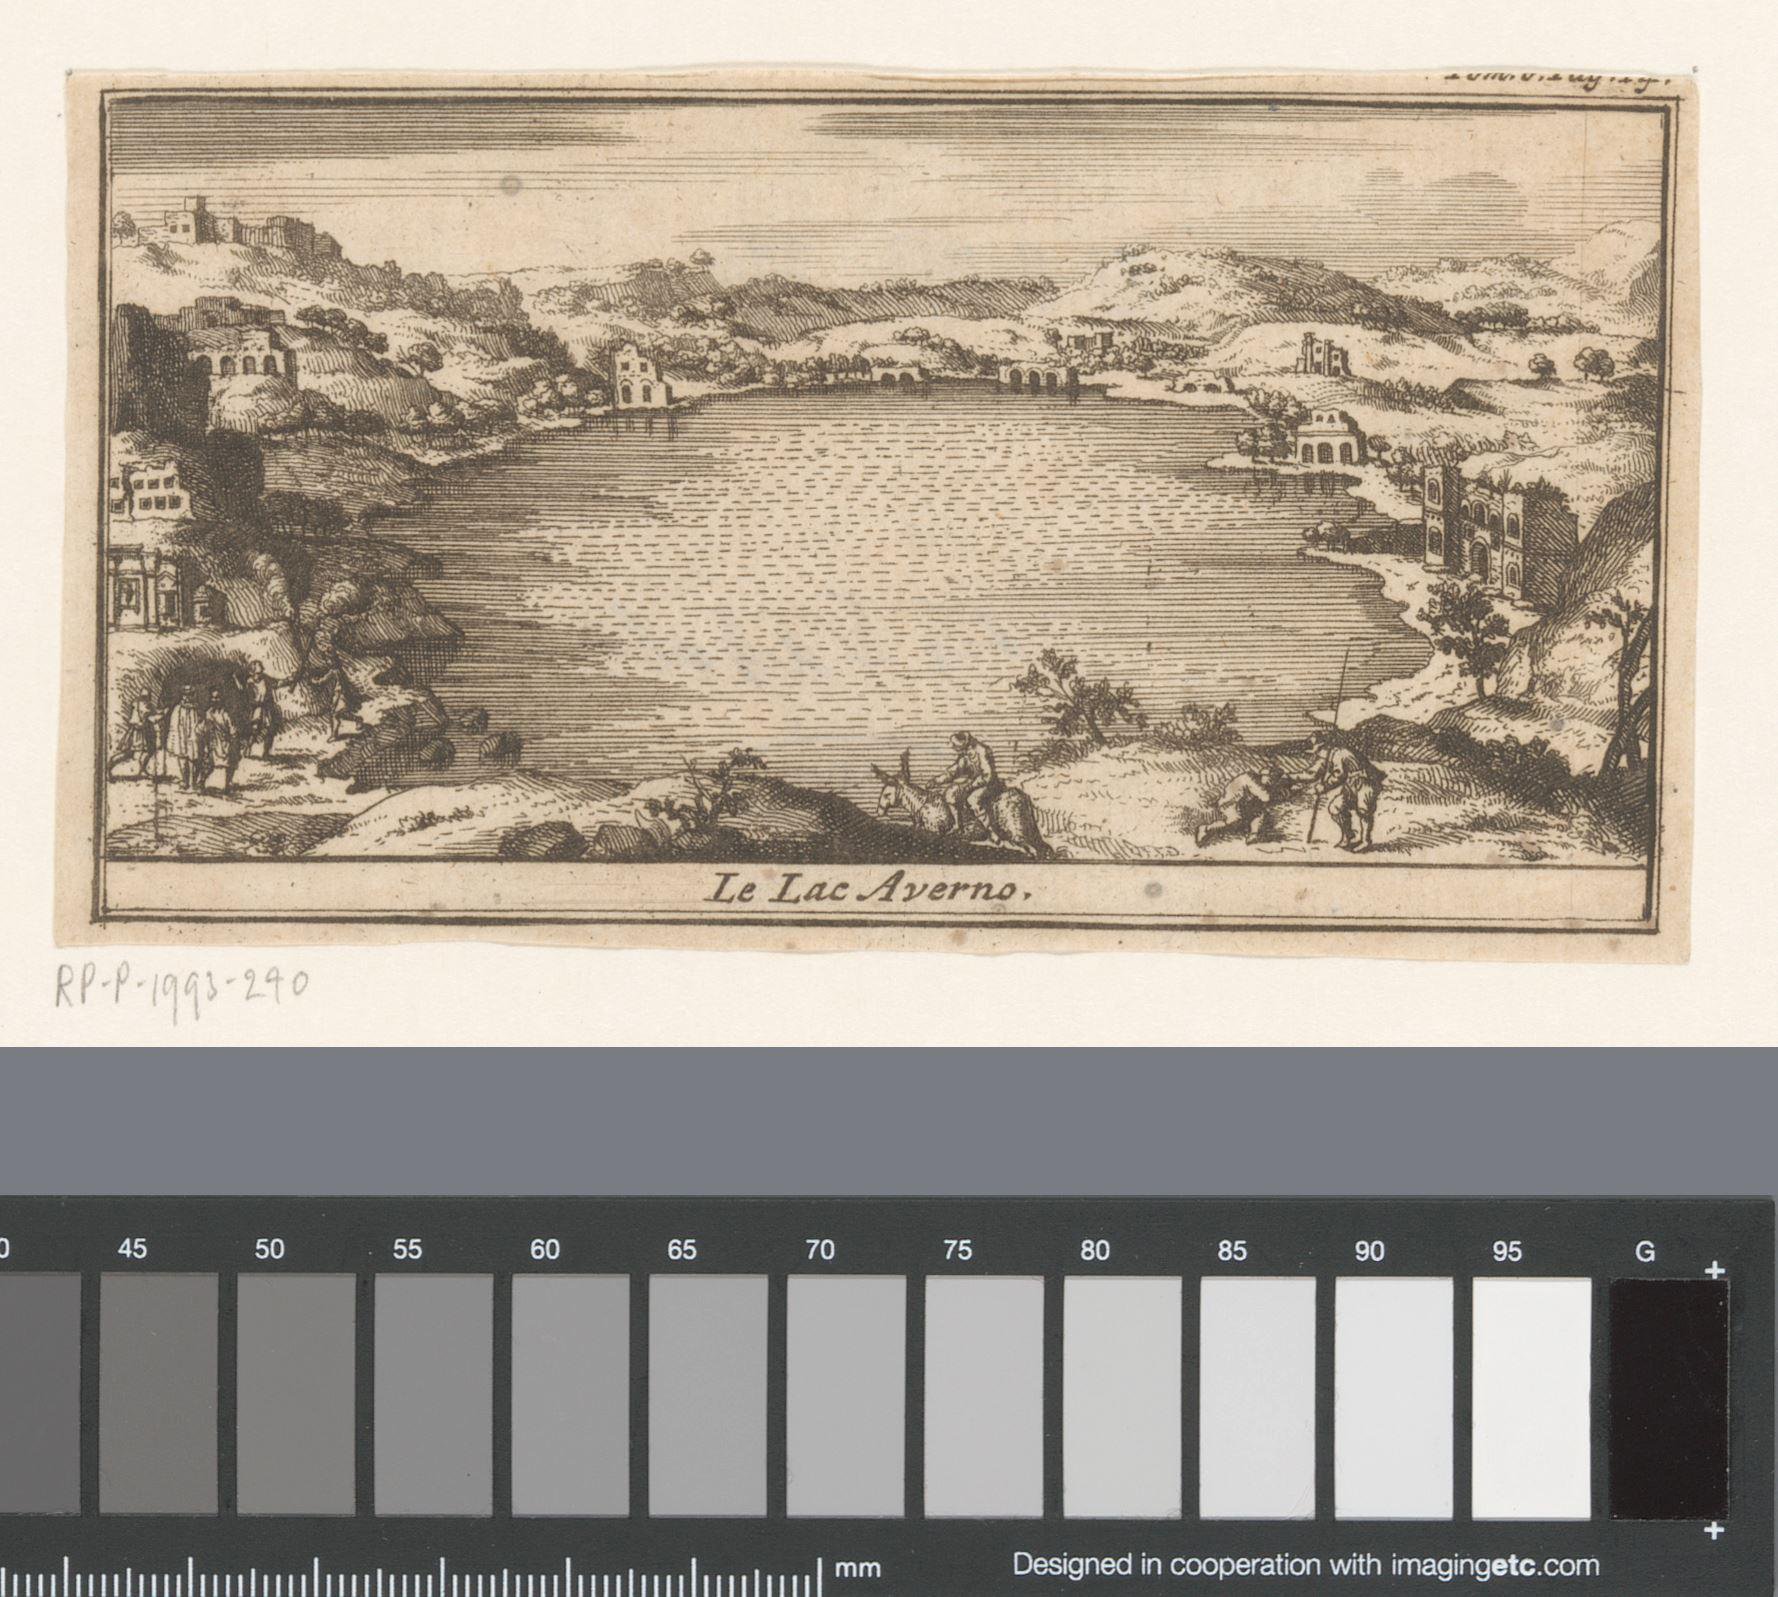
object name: print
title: Landschappen in Italië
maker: pieter van der aa (i)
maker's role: printer, publisher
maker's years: 1659-1733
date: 1682-1730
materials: paper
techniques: etching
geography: leiden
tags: landscapes, landscape with ruins, lake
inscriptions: collector's mark: Lugt 2228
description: Gezicht op het Avernus lacus (Lago d'Averno), een in een uitgebrande krater gelegen meer in Campanië ten zuidoosten van Cumae. Rond het meer liggen verschillende ruïnes.